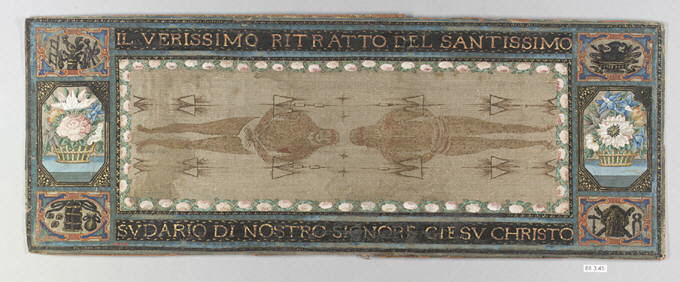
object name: winding sheet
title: Reproduction of a winding sheet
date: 1801-1900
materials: textile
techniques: painting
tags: human figures,flowers